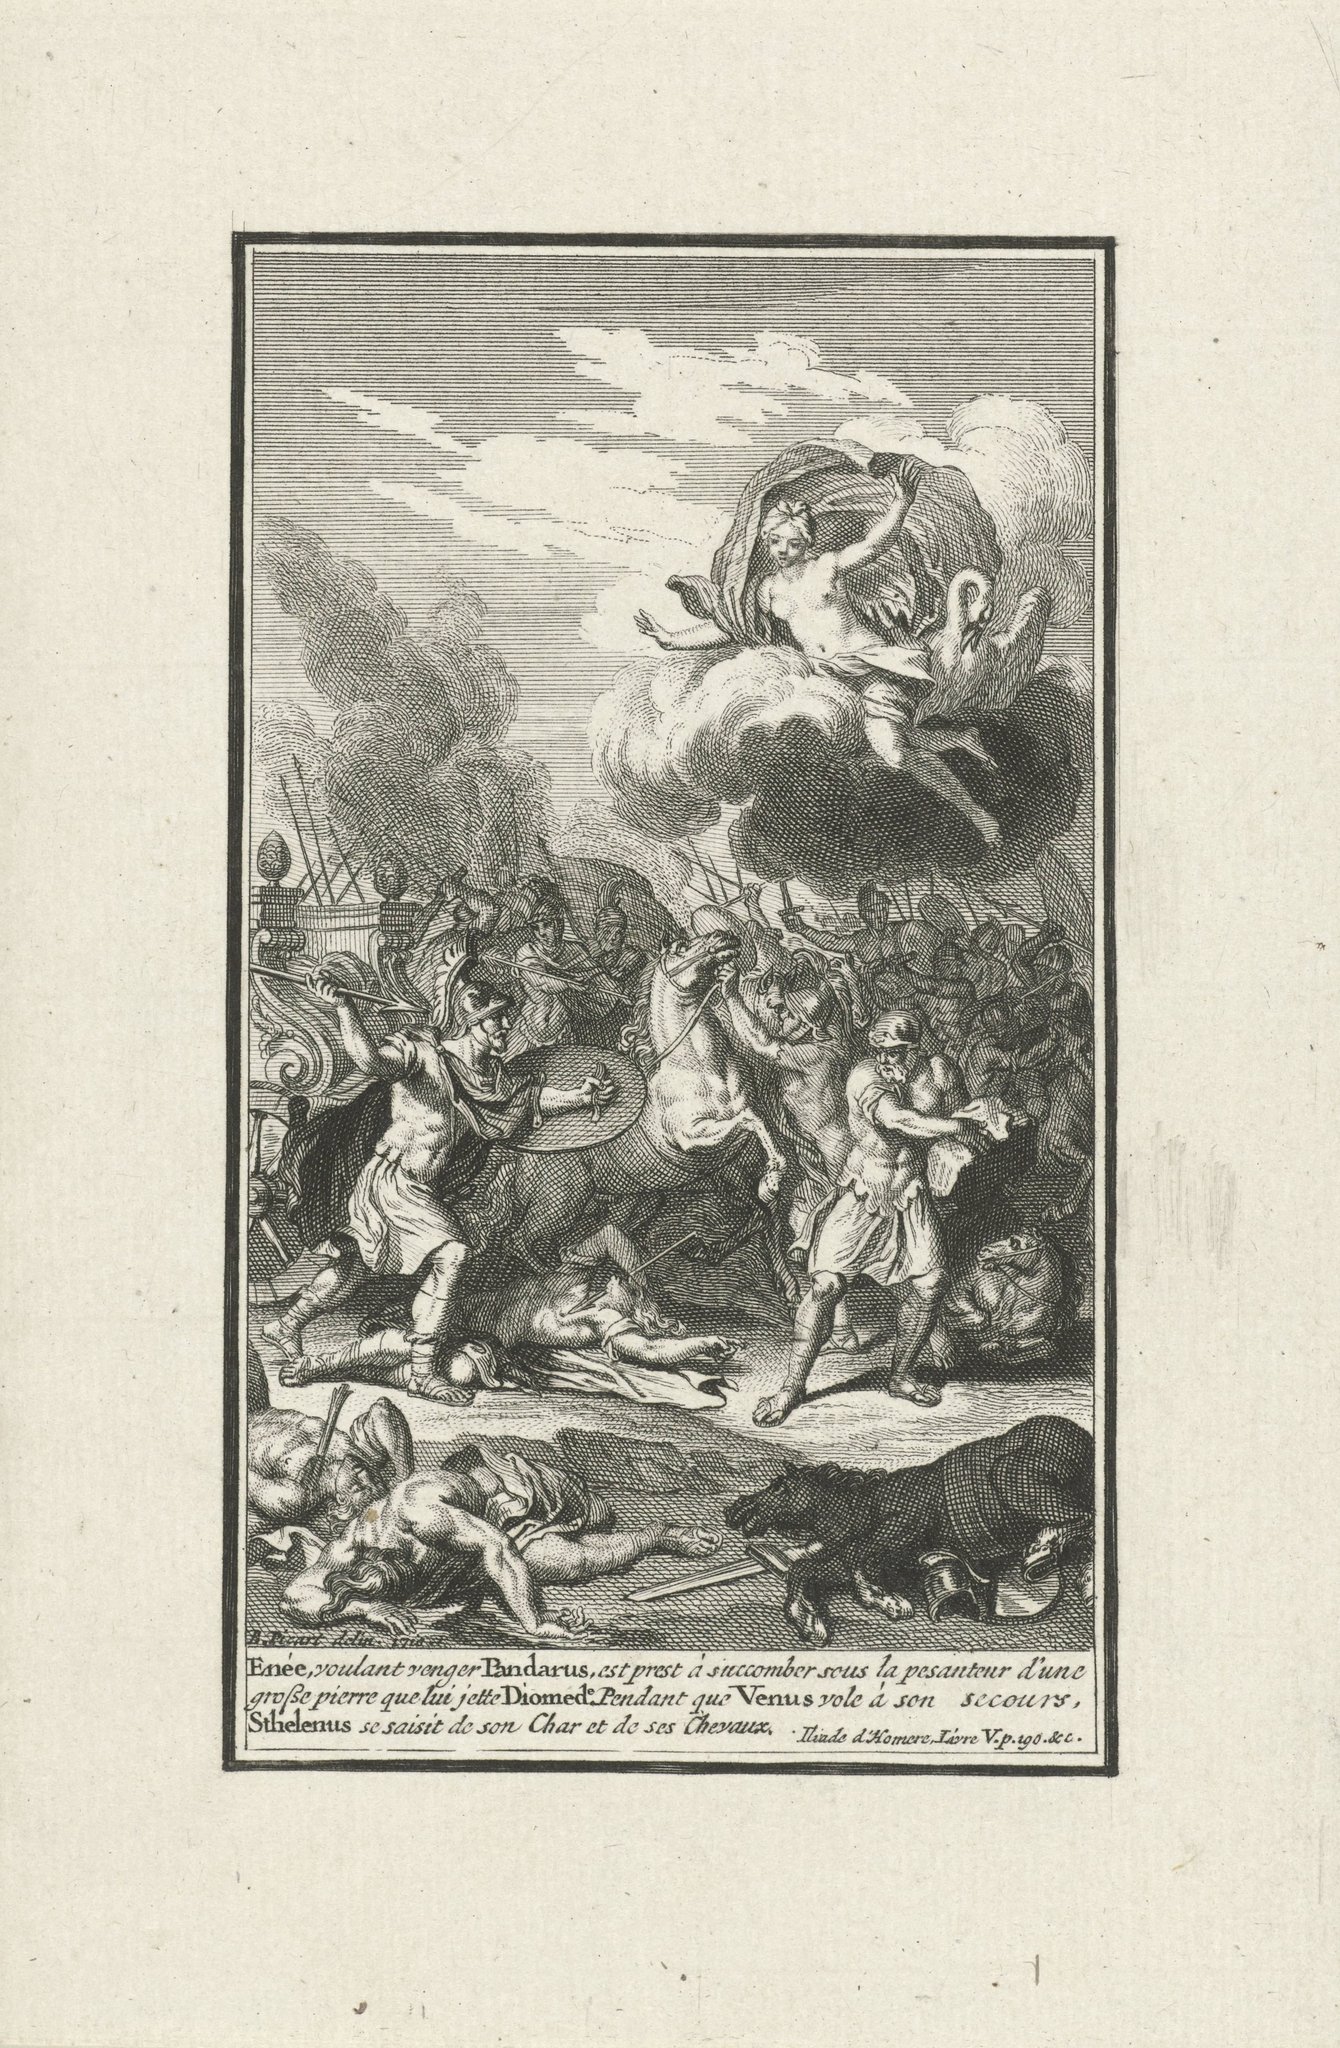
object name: print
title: Aeneas wil het lichaam van Pandarus redden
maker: bernard picart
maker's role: draughtsman, print maker, publisher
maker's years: 1673-1733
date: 1710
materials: paper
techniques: engraving, etching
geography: amsterdam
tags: aeneas tries to save the body of pandarus but is hit by a stone thrown by diomedes; venus comes to aeneas' rescue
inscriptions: collector's mark: Lugt 240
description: Aeneas probeert het lichaam van Pandarus te redden, maar wordt daarbij gehinderd door Diomedes die een steen naar hem wil gooien. Venus komt op een wolk aangevlogen om hem te redden. In de marge een onderschrift in het Frans.